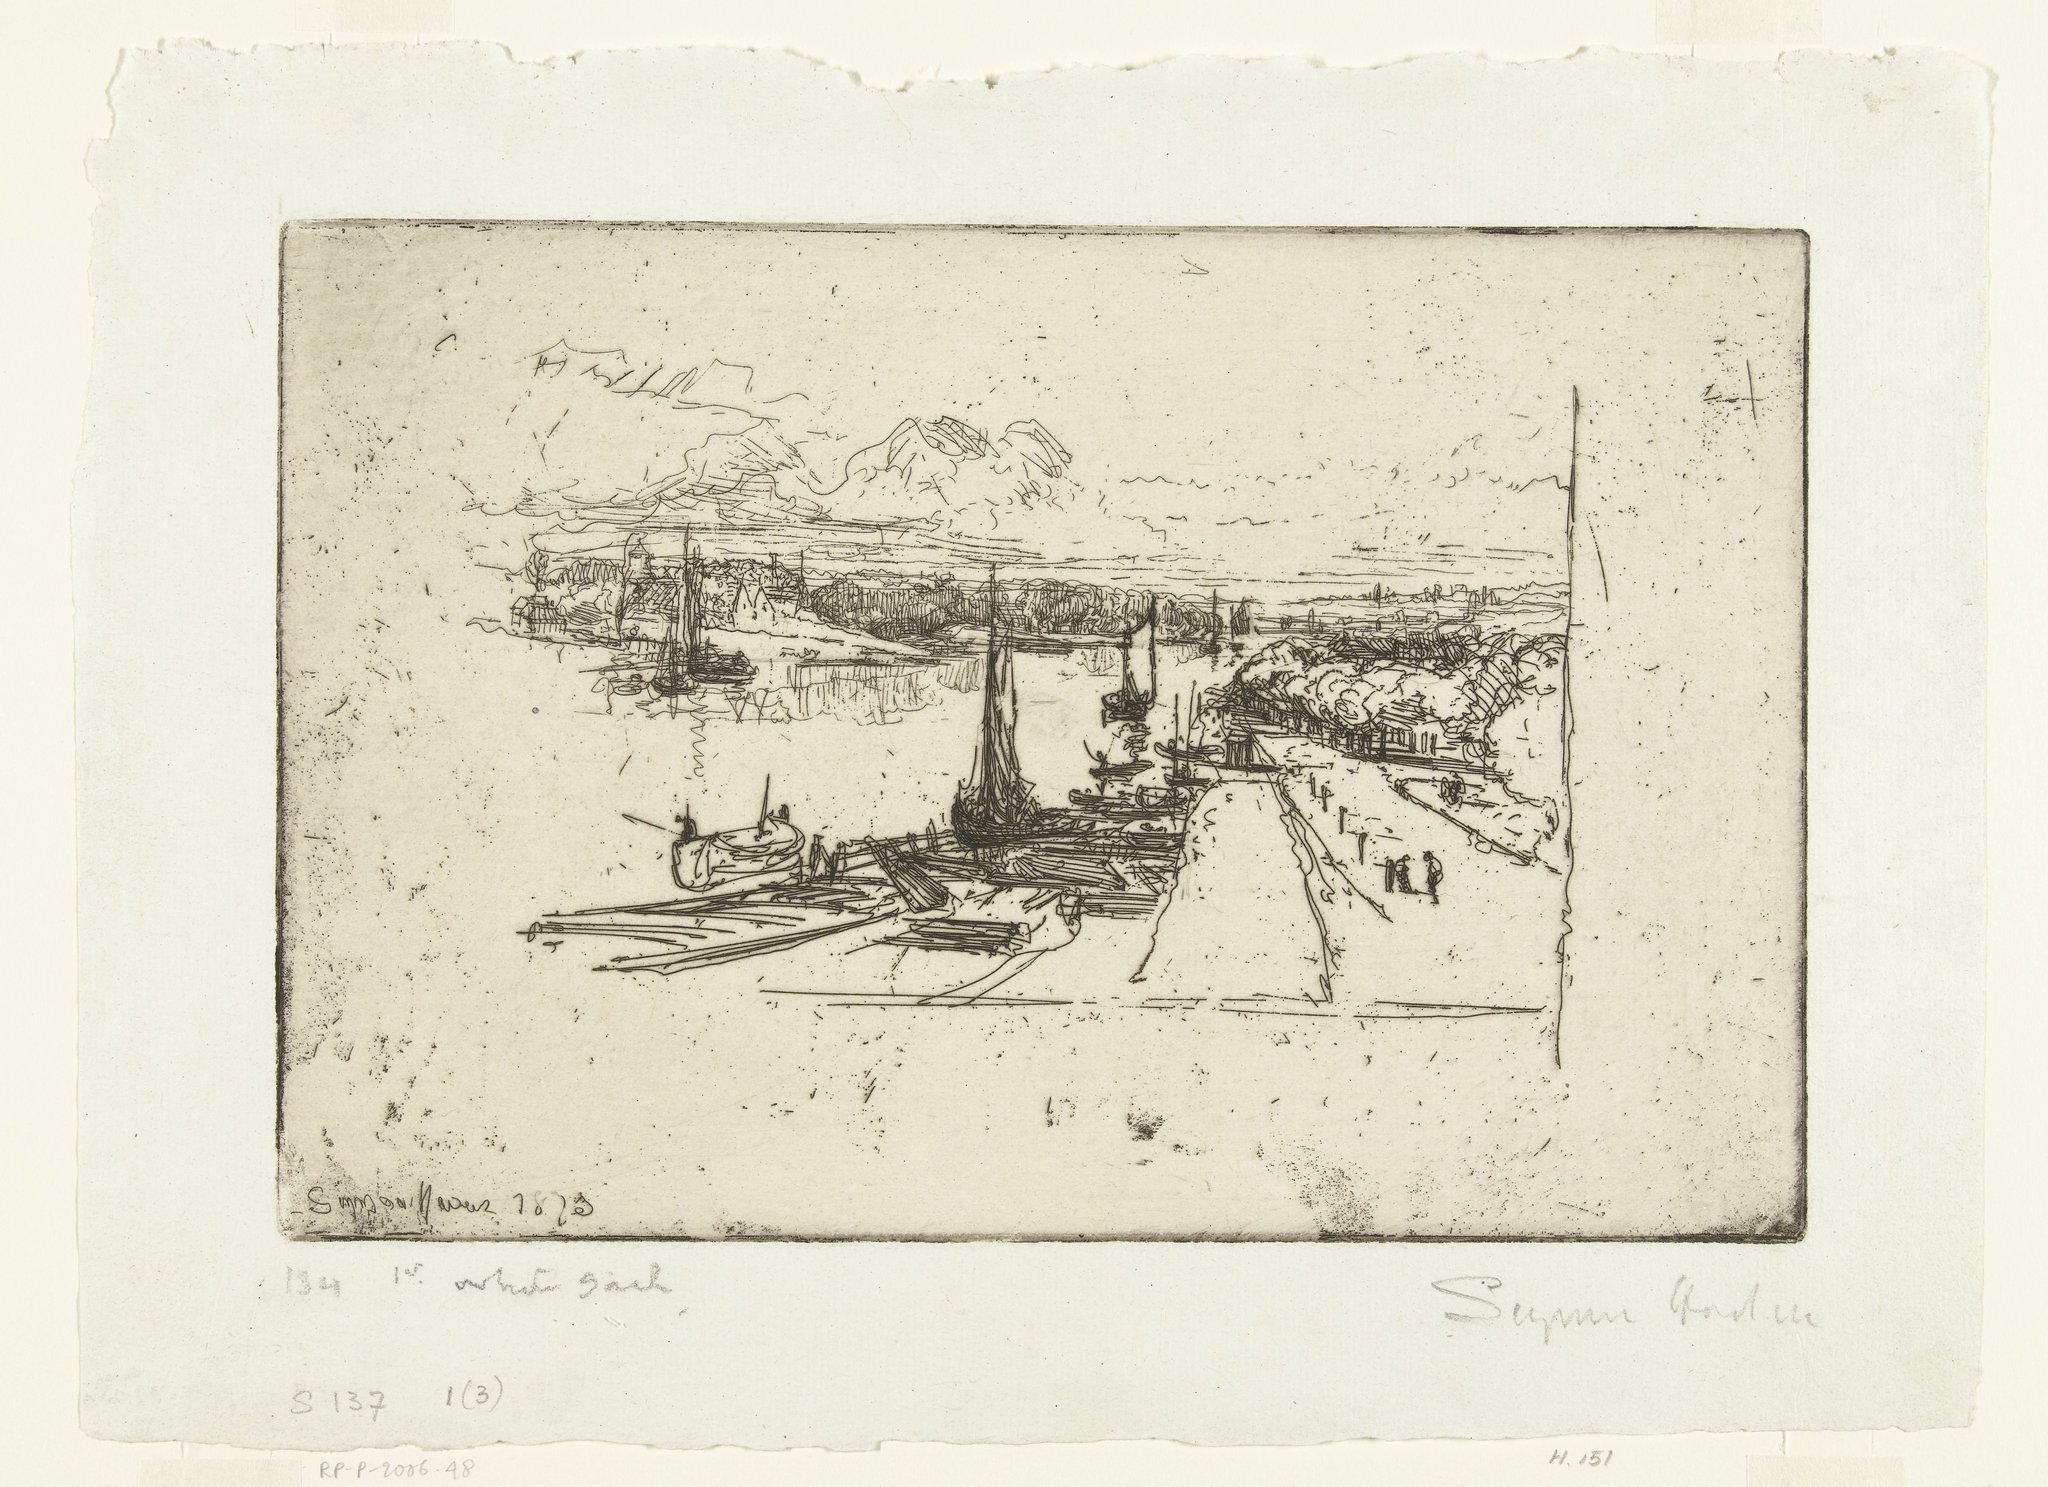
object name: print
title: De Amstel vanuit het Amstelhotel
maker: francis seymour-haden (sir)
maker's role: print maker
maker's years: 1818-1910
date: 1873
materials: paper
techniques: etching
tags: amstel (rivier)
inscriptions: date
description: Gezicht op de Amstel, gezien vanuit een raam van het Amstelhotel te Amsterdam.